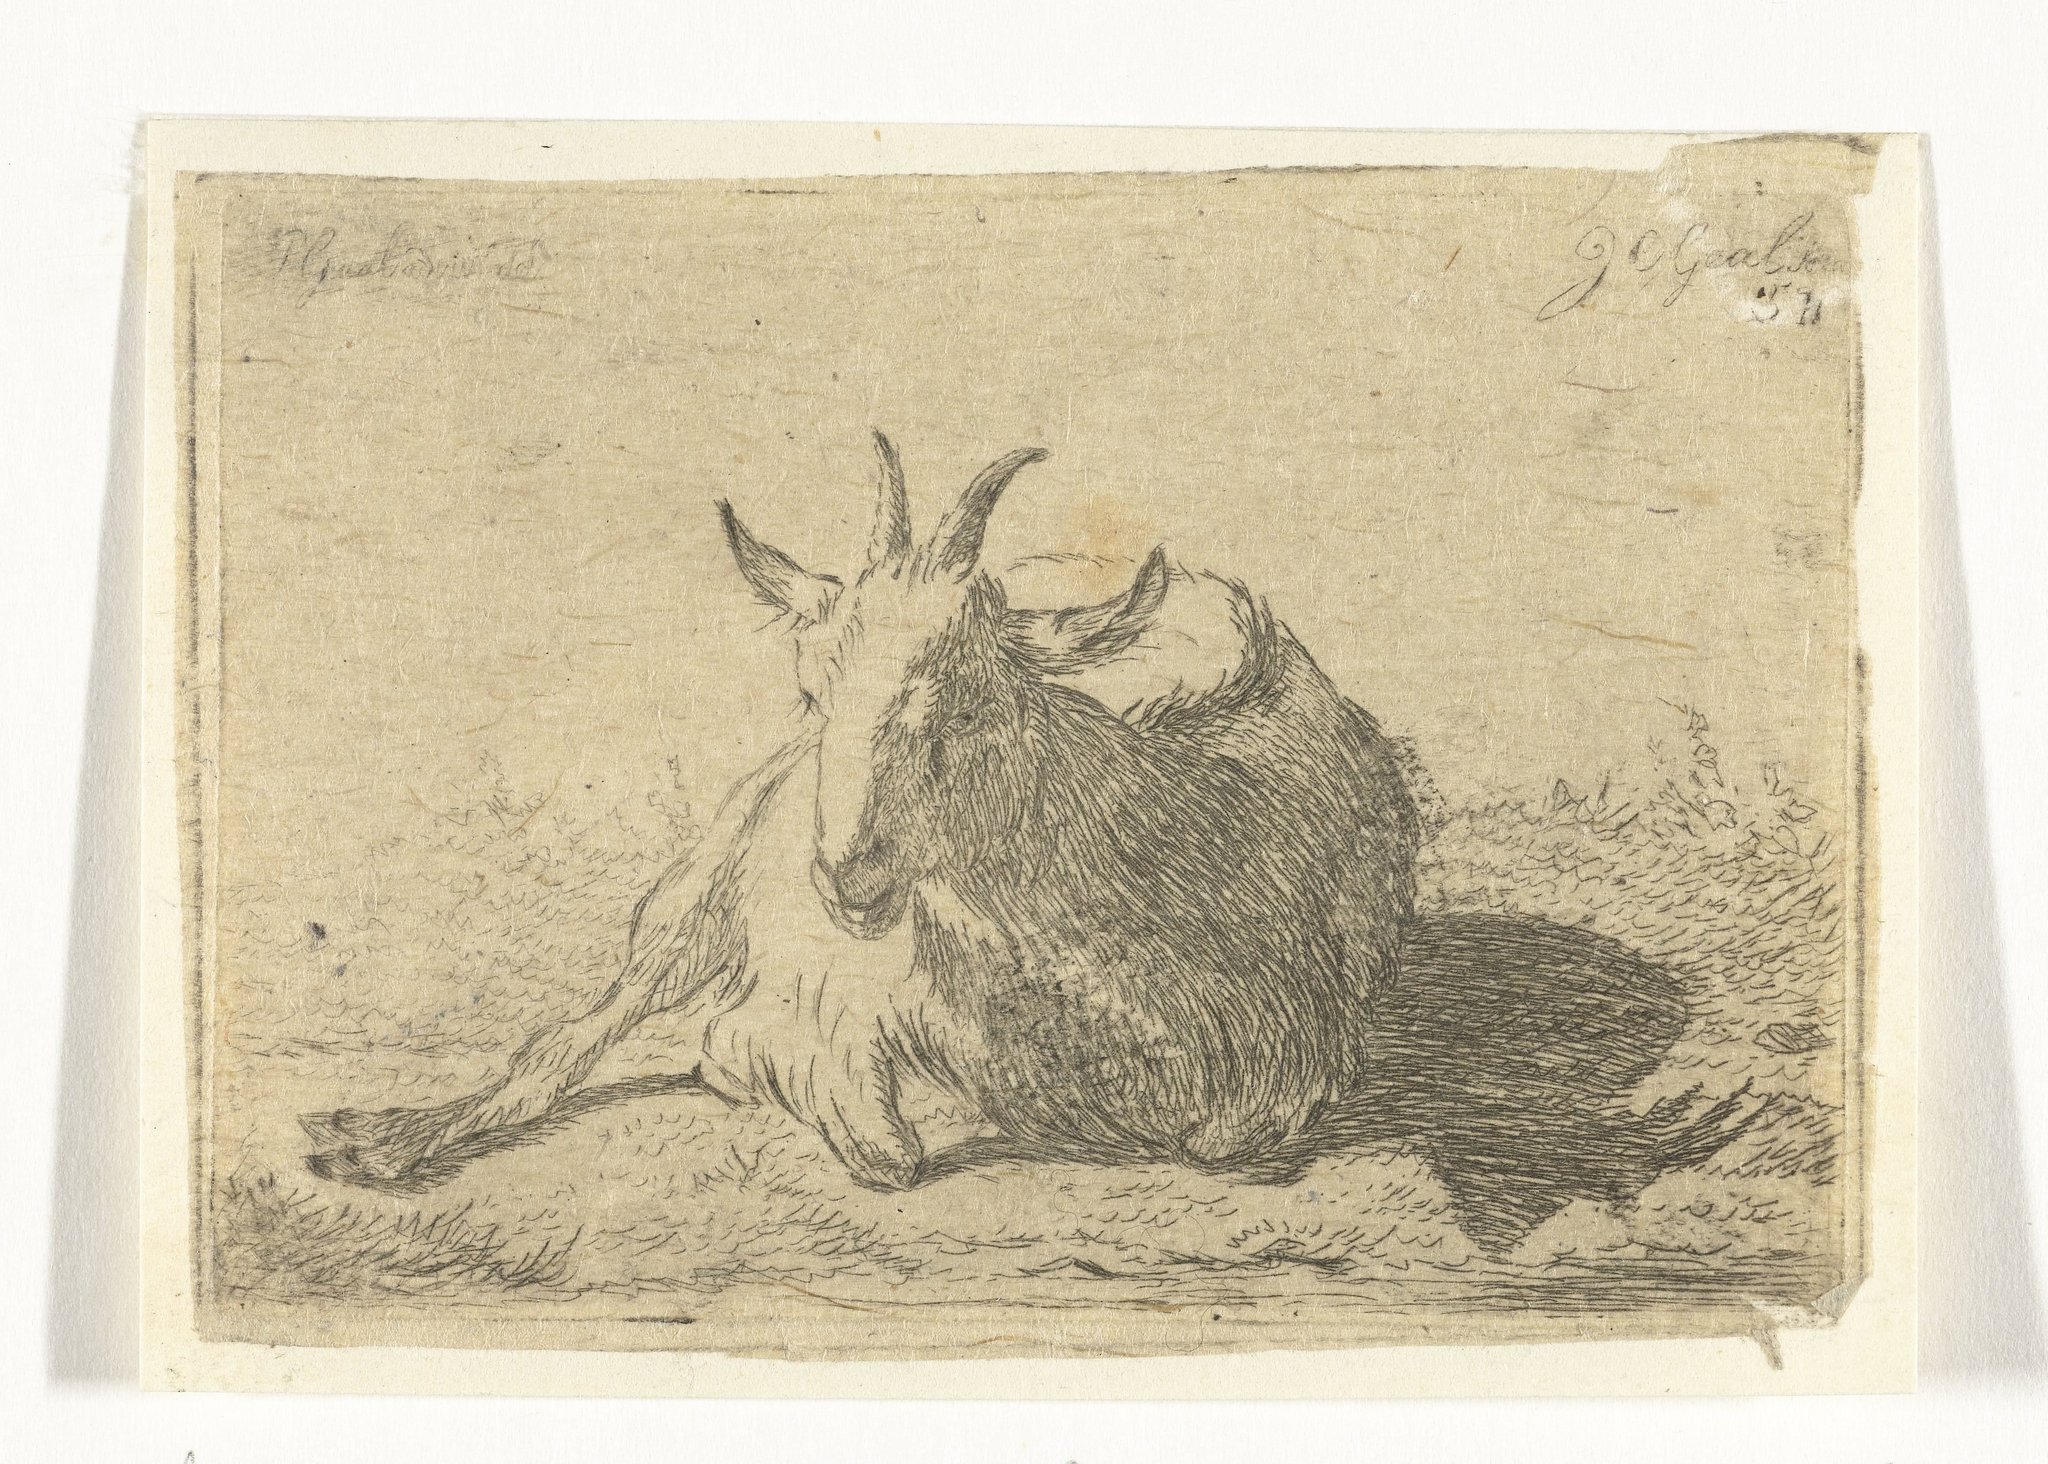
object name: print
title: Liggende geit, naar links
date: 1851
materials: paper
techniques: etching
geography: netherlands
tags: goat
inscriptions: collector's mark: Lugt 2228